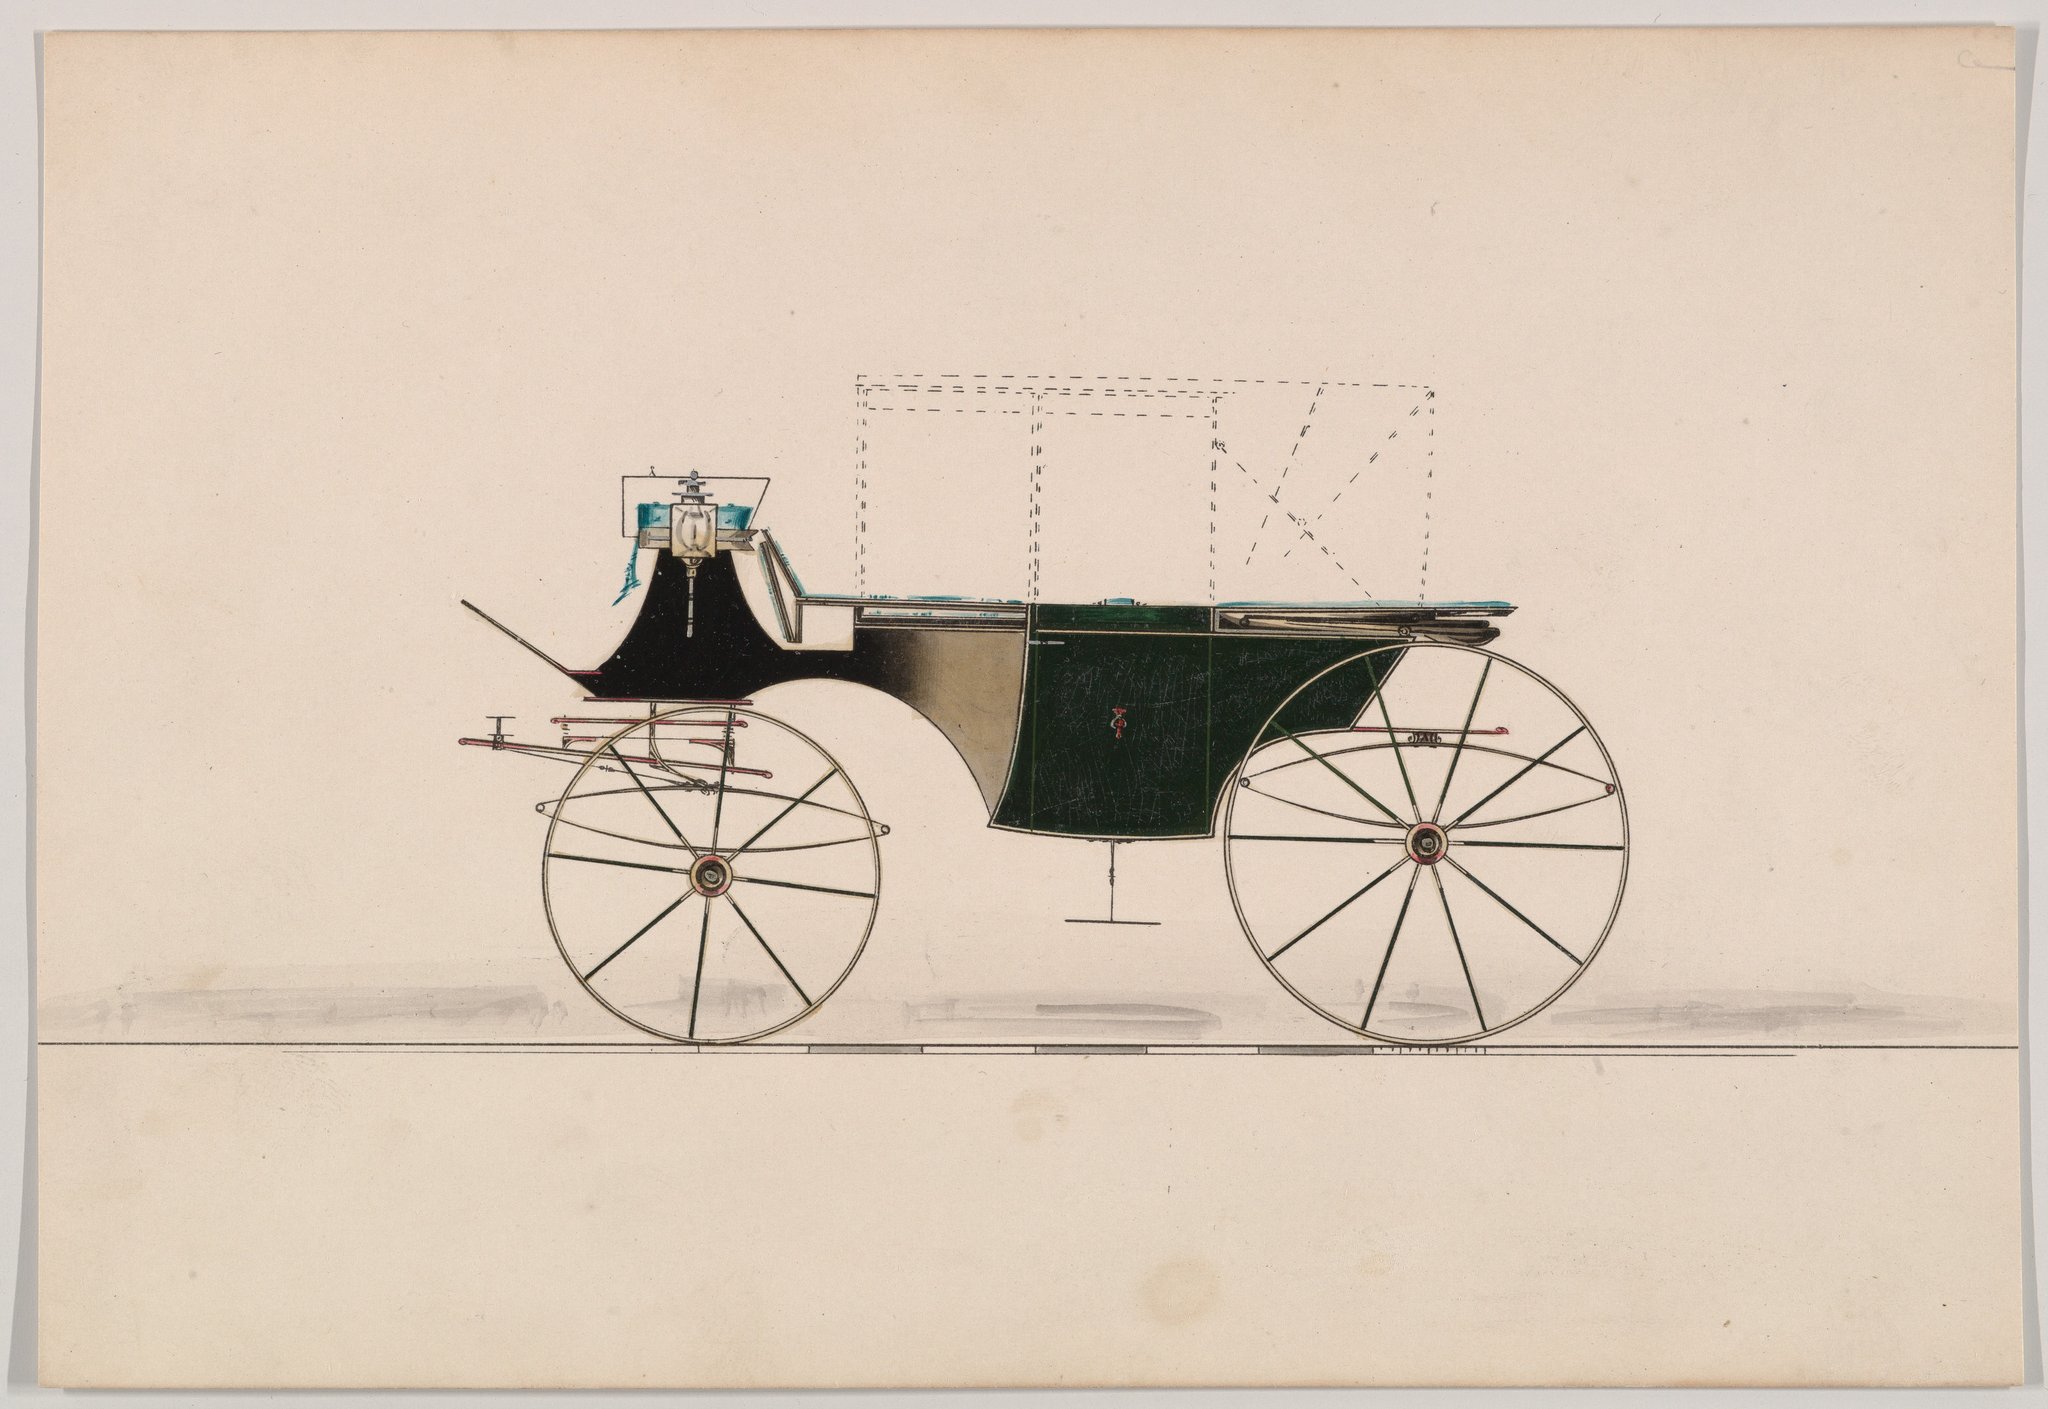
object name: drawing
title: Design for Landaulet (unnumbered)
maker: brewster & co.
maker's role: manufacturer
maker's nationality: american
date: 1850-1870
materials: gouache, ink, watercolor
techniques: pen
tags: carriages